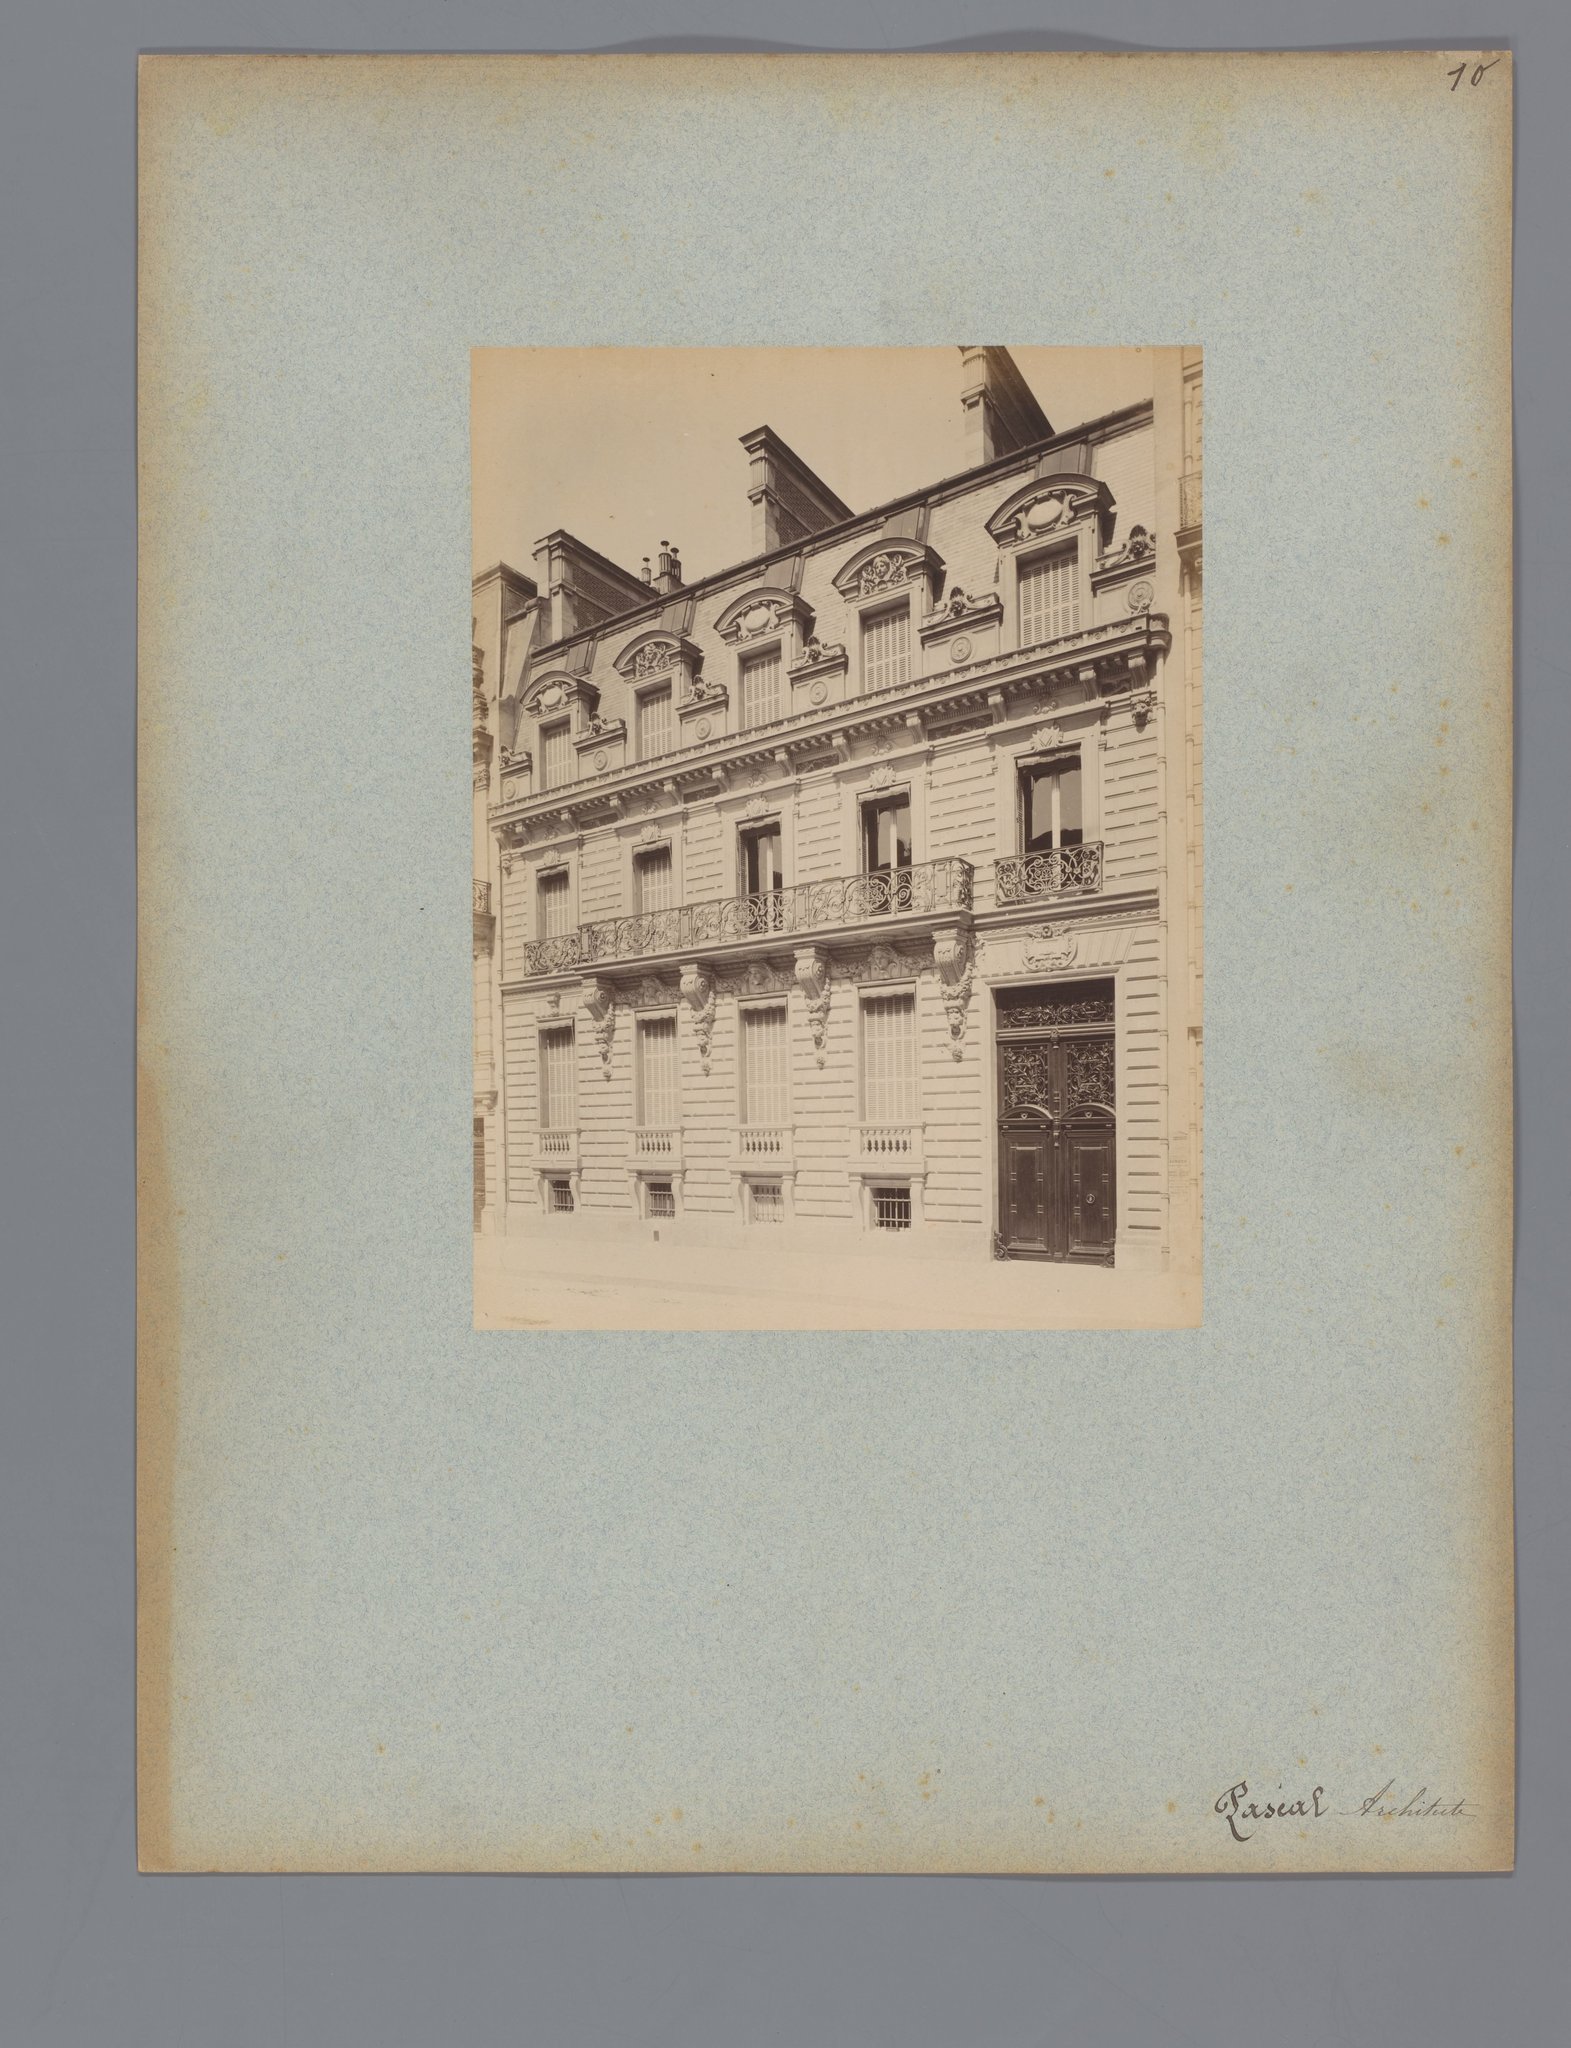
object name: photograph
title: Façade van een woonhuis in Parijs, ontworpen door Jean Louis Pascal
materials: photographic support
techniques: albumen print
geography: paris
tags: urban housing, façade (of house or building), paris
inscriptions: number: ‘10’, name: ‘Pascal Architecte’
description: Deze foto maakt deel uit van een omslag met 35 foto's en een titelblad.